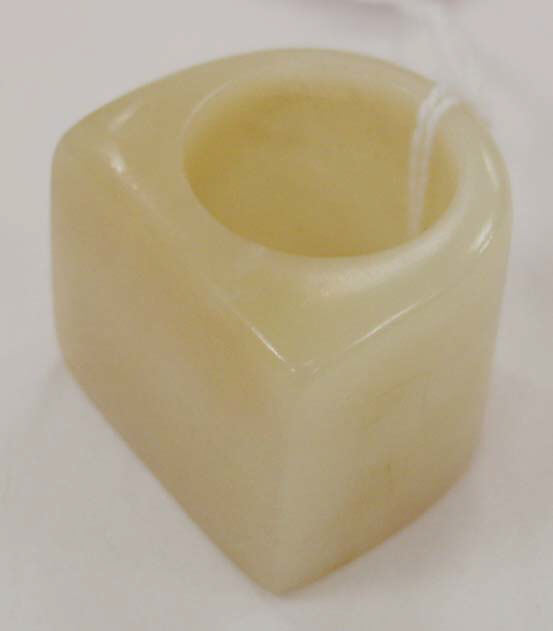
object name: ring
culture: chinese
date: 1801-1900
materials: jade